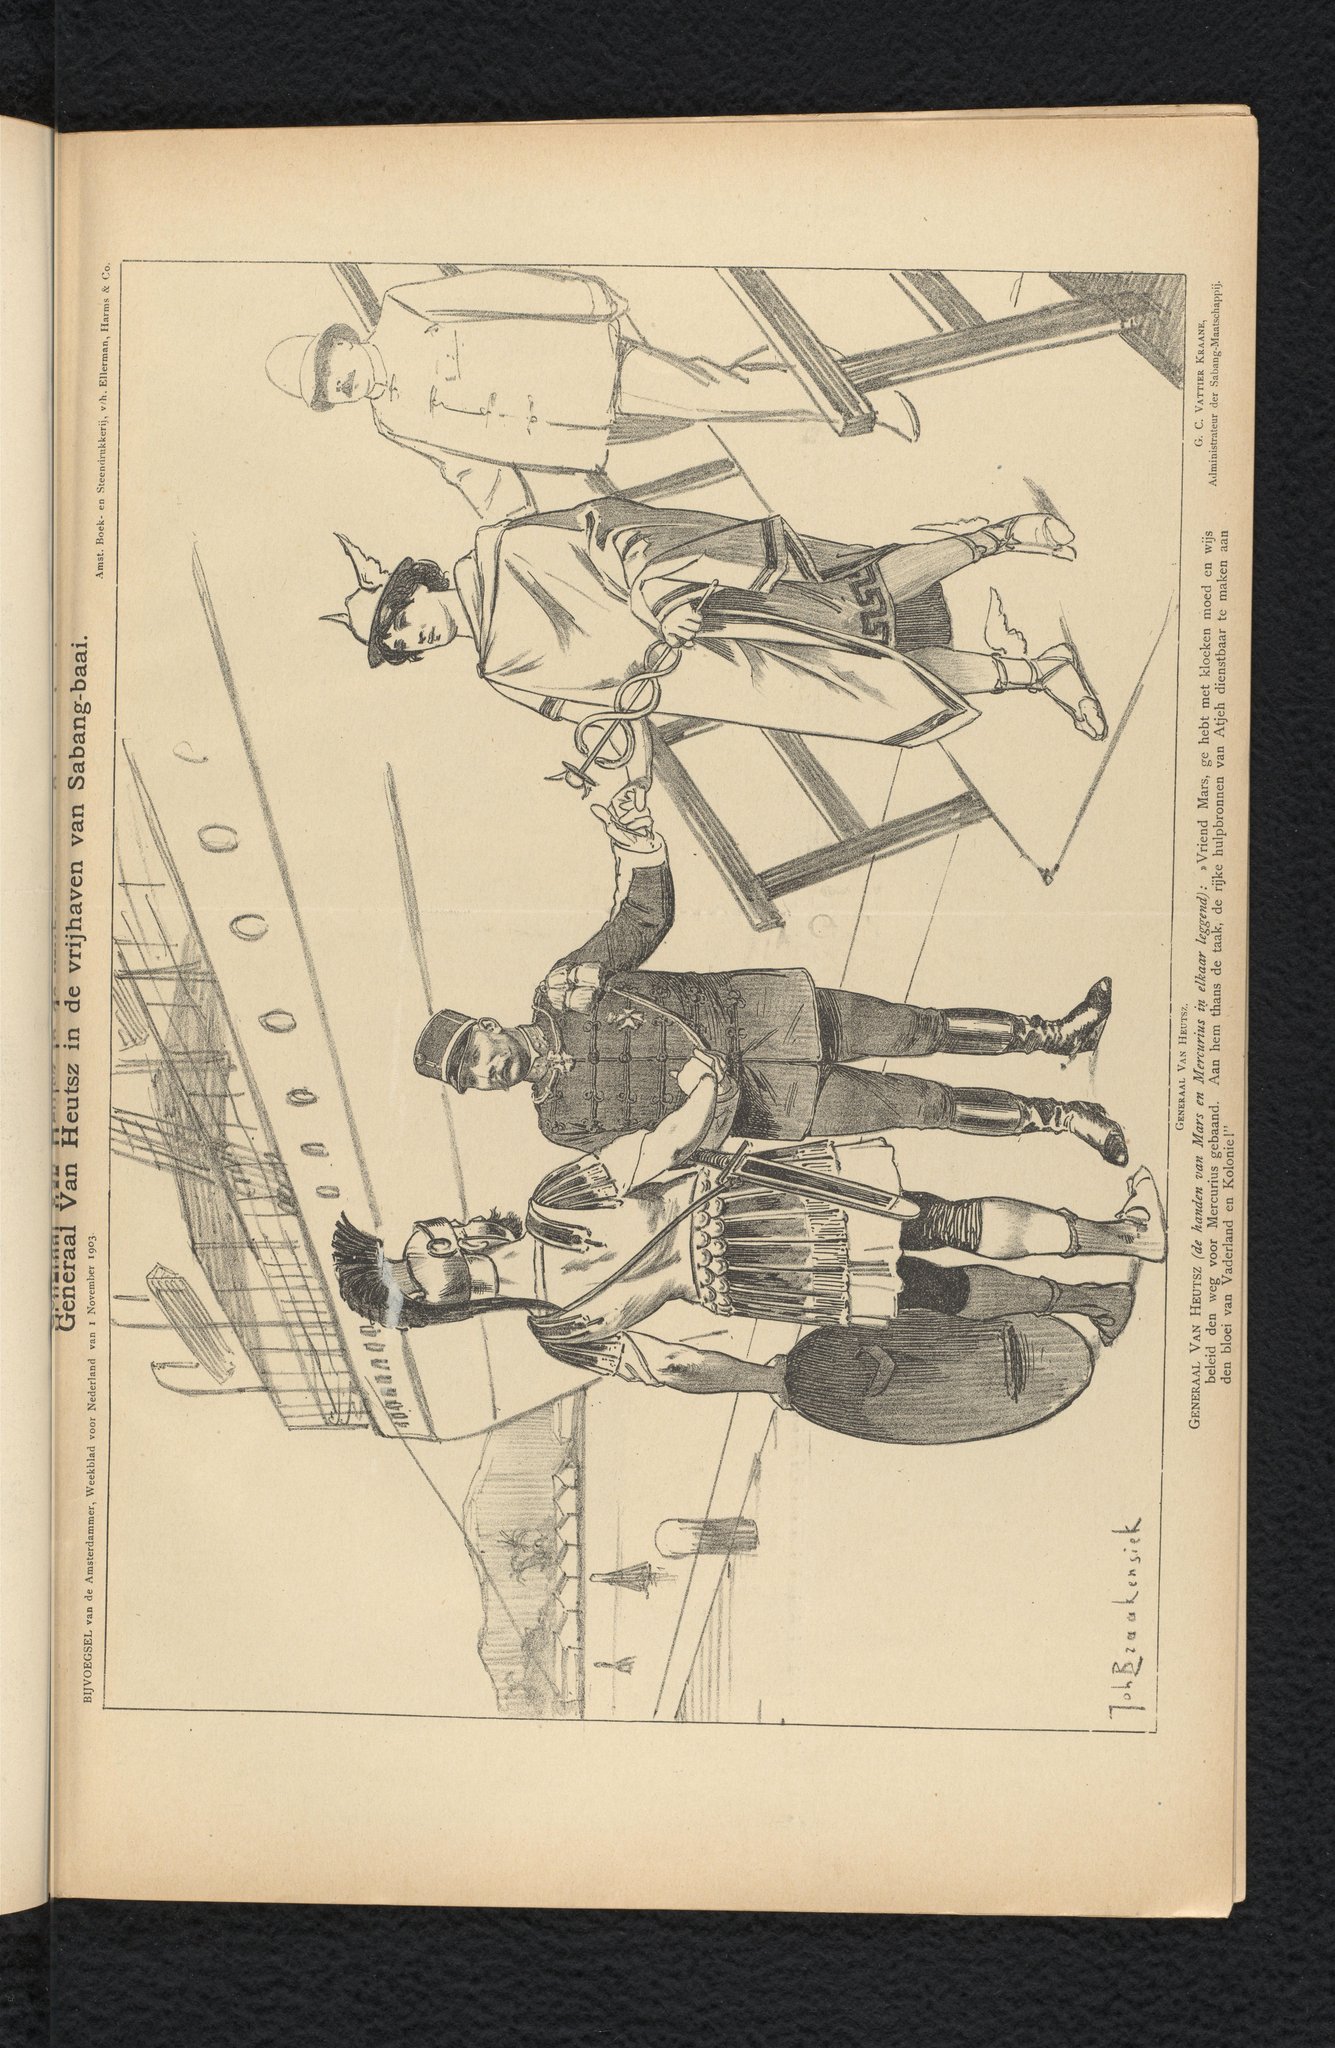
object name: cartoon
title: Generaal Van Heutsz in de vrijhaven van Sabang-baai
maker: johan braakensiek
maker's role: draughtsman, print maker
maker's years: 1858-1940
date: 1903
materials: paper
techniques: lithograph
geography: amsterdam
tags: harbour, shaking hands, 'dextrarum junctio', specific aspects, allegorical aspects of mercury; mercury as patron, specific aspects, allegorical aspects of mars; mars as patron, political caricatures and satires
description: Generaal Van Heutsz verbindt Mars met Mercurius bij diens aankomst in de haven van Sabang op Atjeh. Naar aanleiding van de ontwikkeling van Sabang tot een economisch belangrijke haven in de voormalige kolonie Nederlands-Indië.